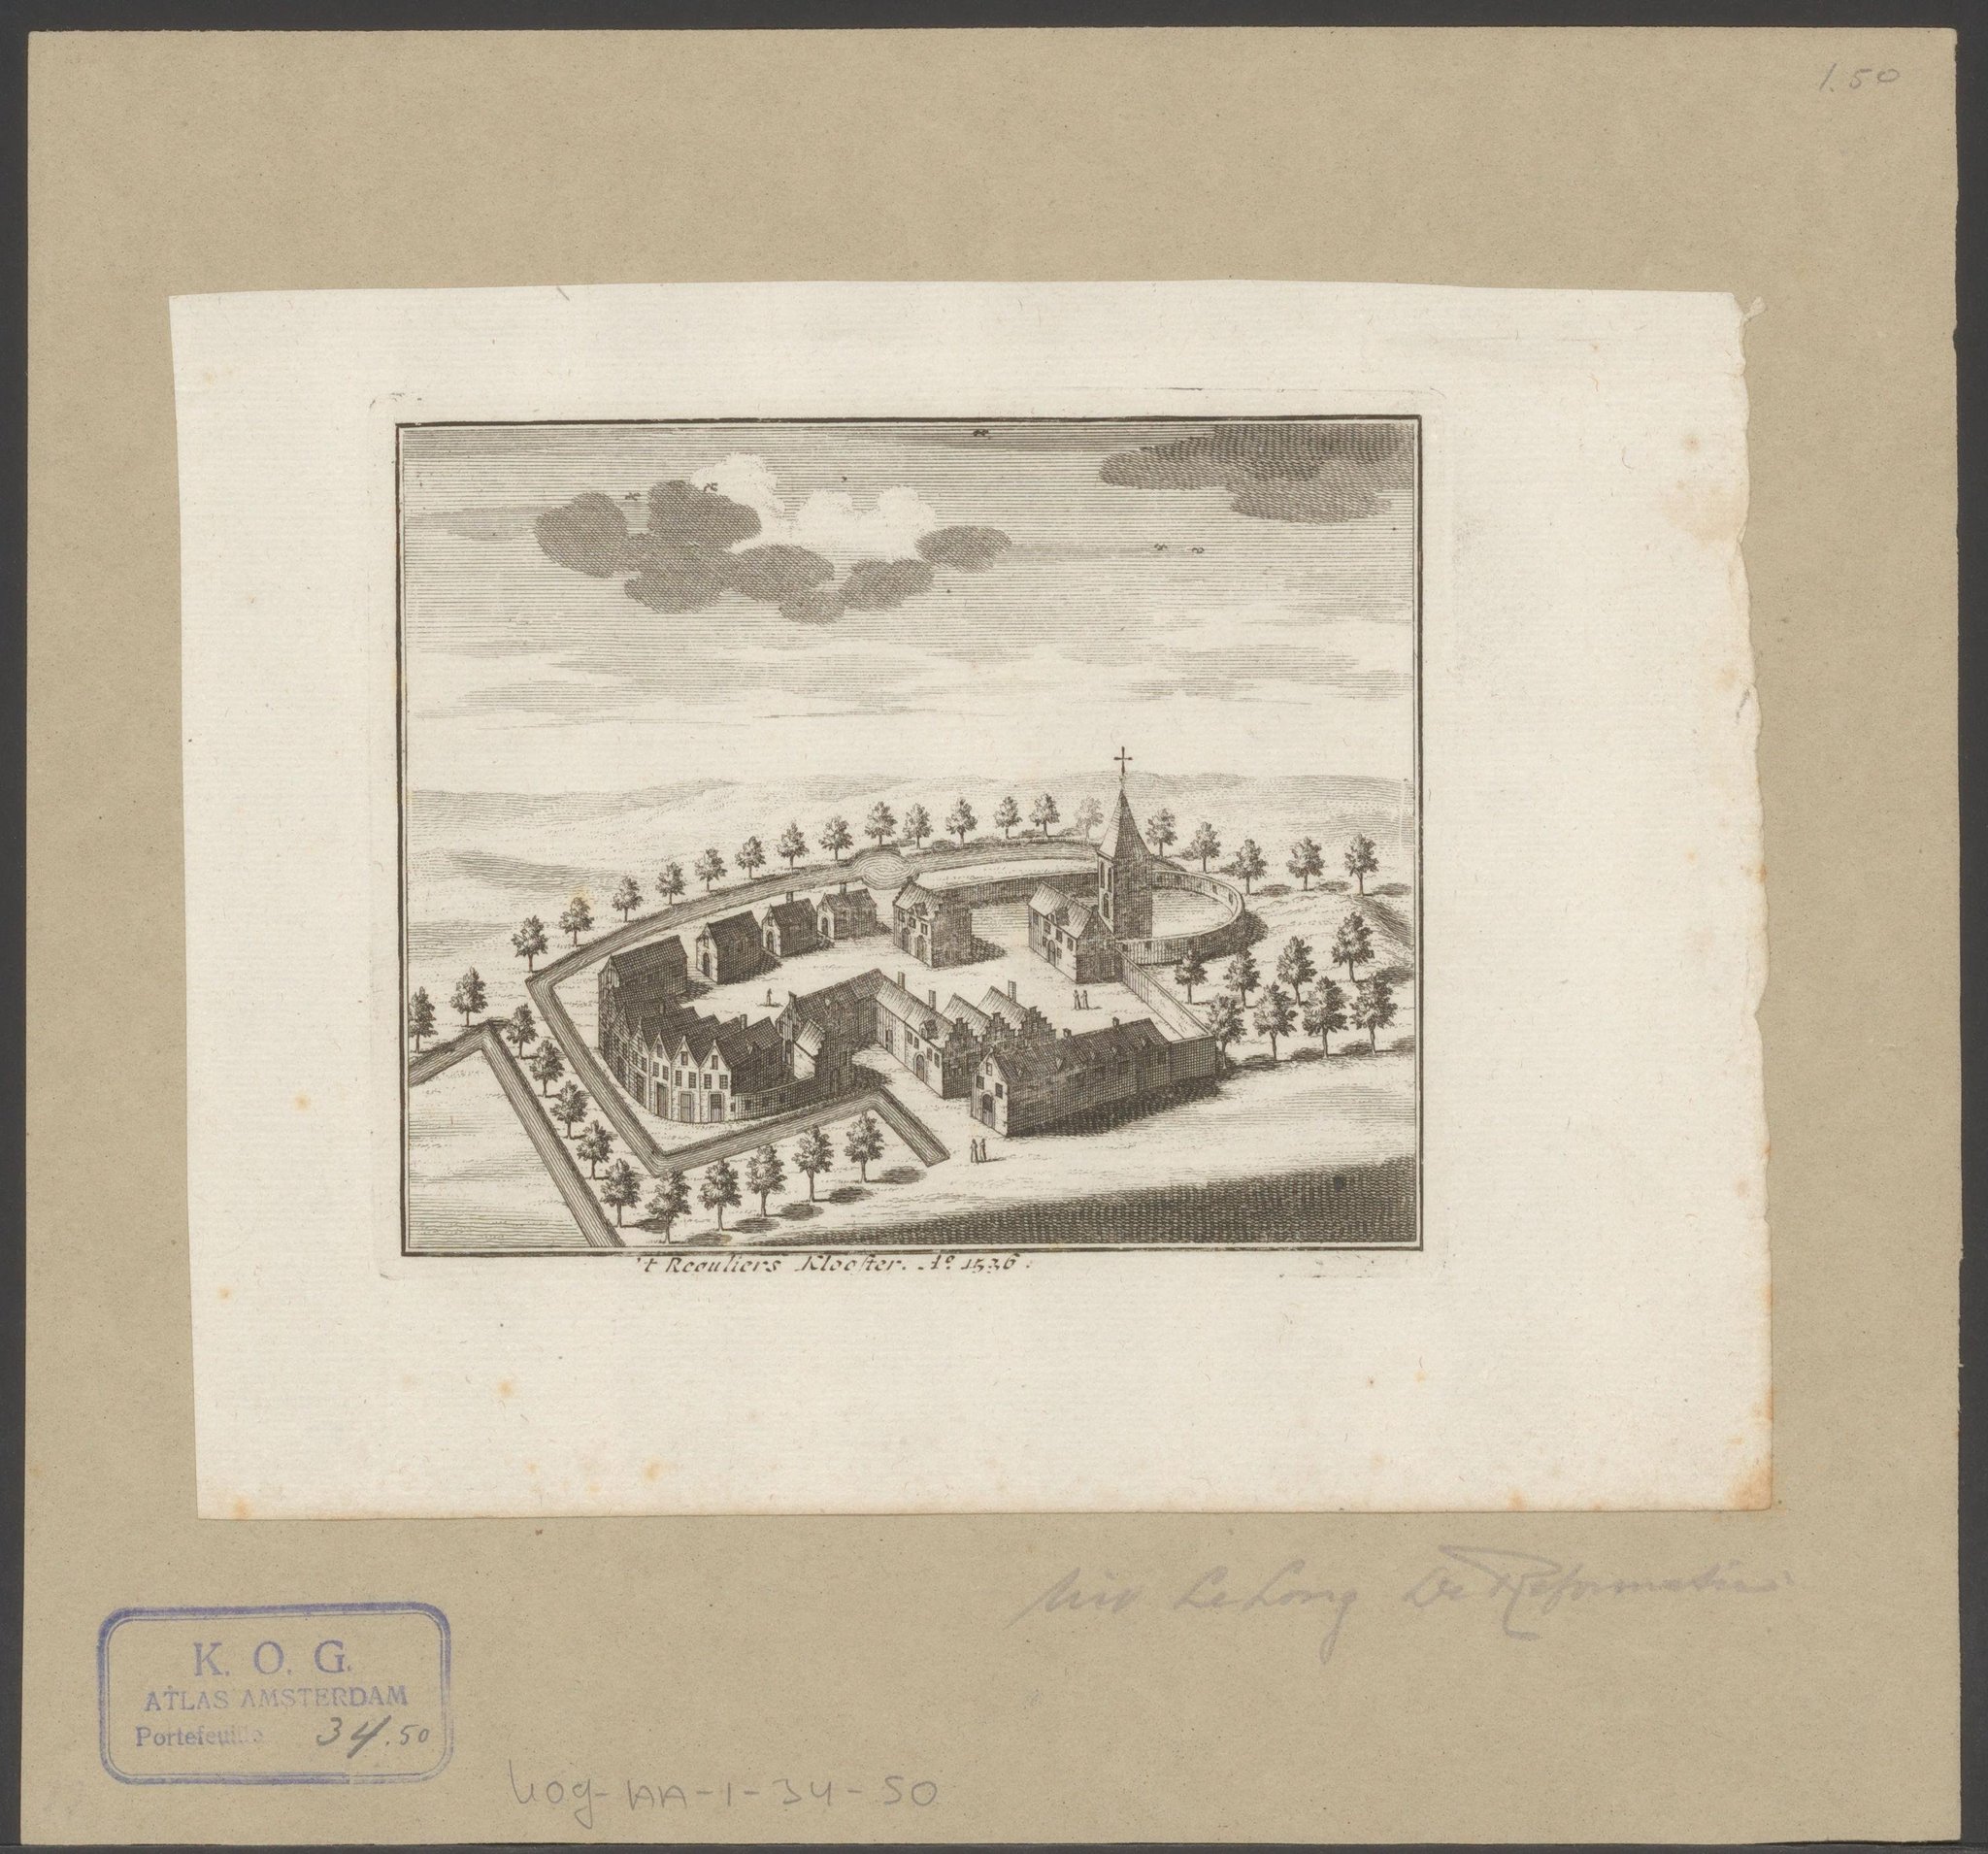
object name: print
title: 't Reguliers Klooster. Ao. 1536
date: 1729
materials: paper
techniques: engraving, etching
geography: amsterdam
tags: abbey, monastery, convent ~ roman catholic church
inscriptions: collector's mark: Lugt 1641b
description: Prent mogelijk uit: Long, Isaac le. Historische beschryvinge van de reformatie der stadt Amsterdam (…). Amsterdam: Johannes van Septeren (I), 1729.